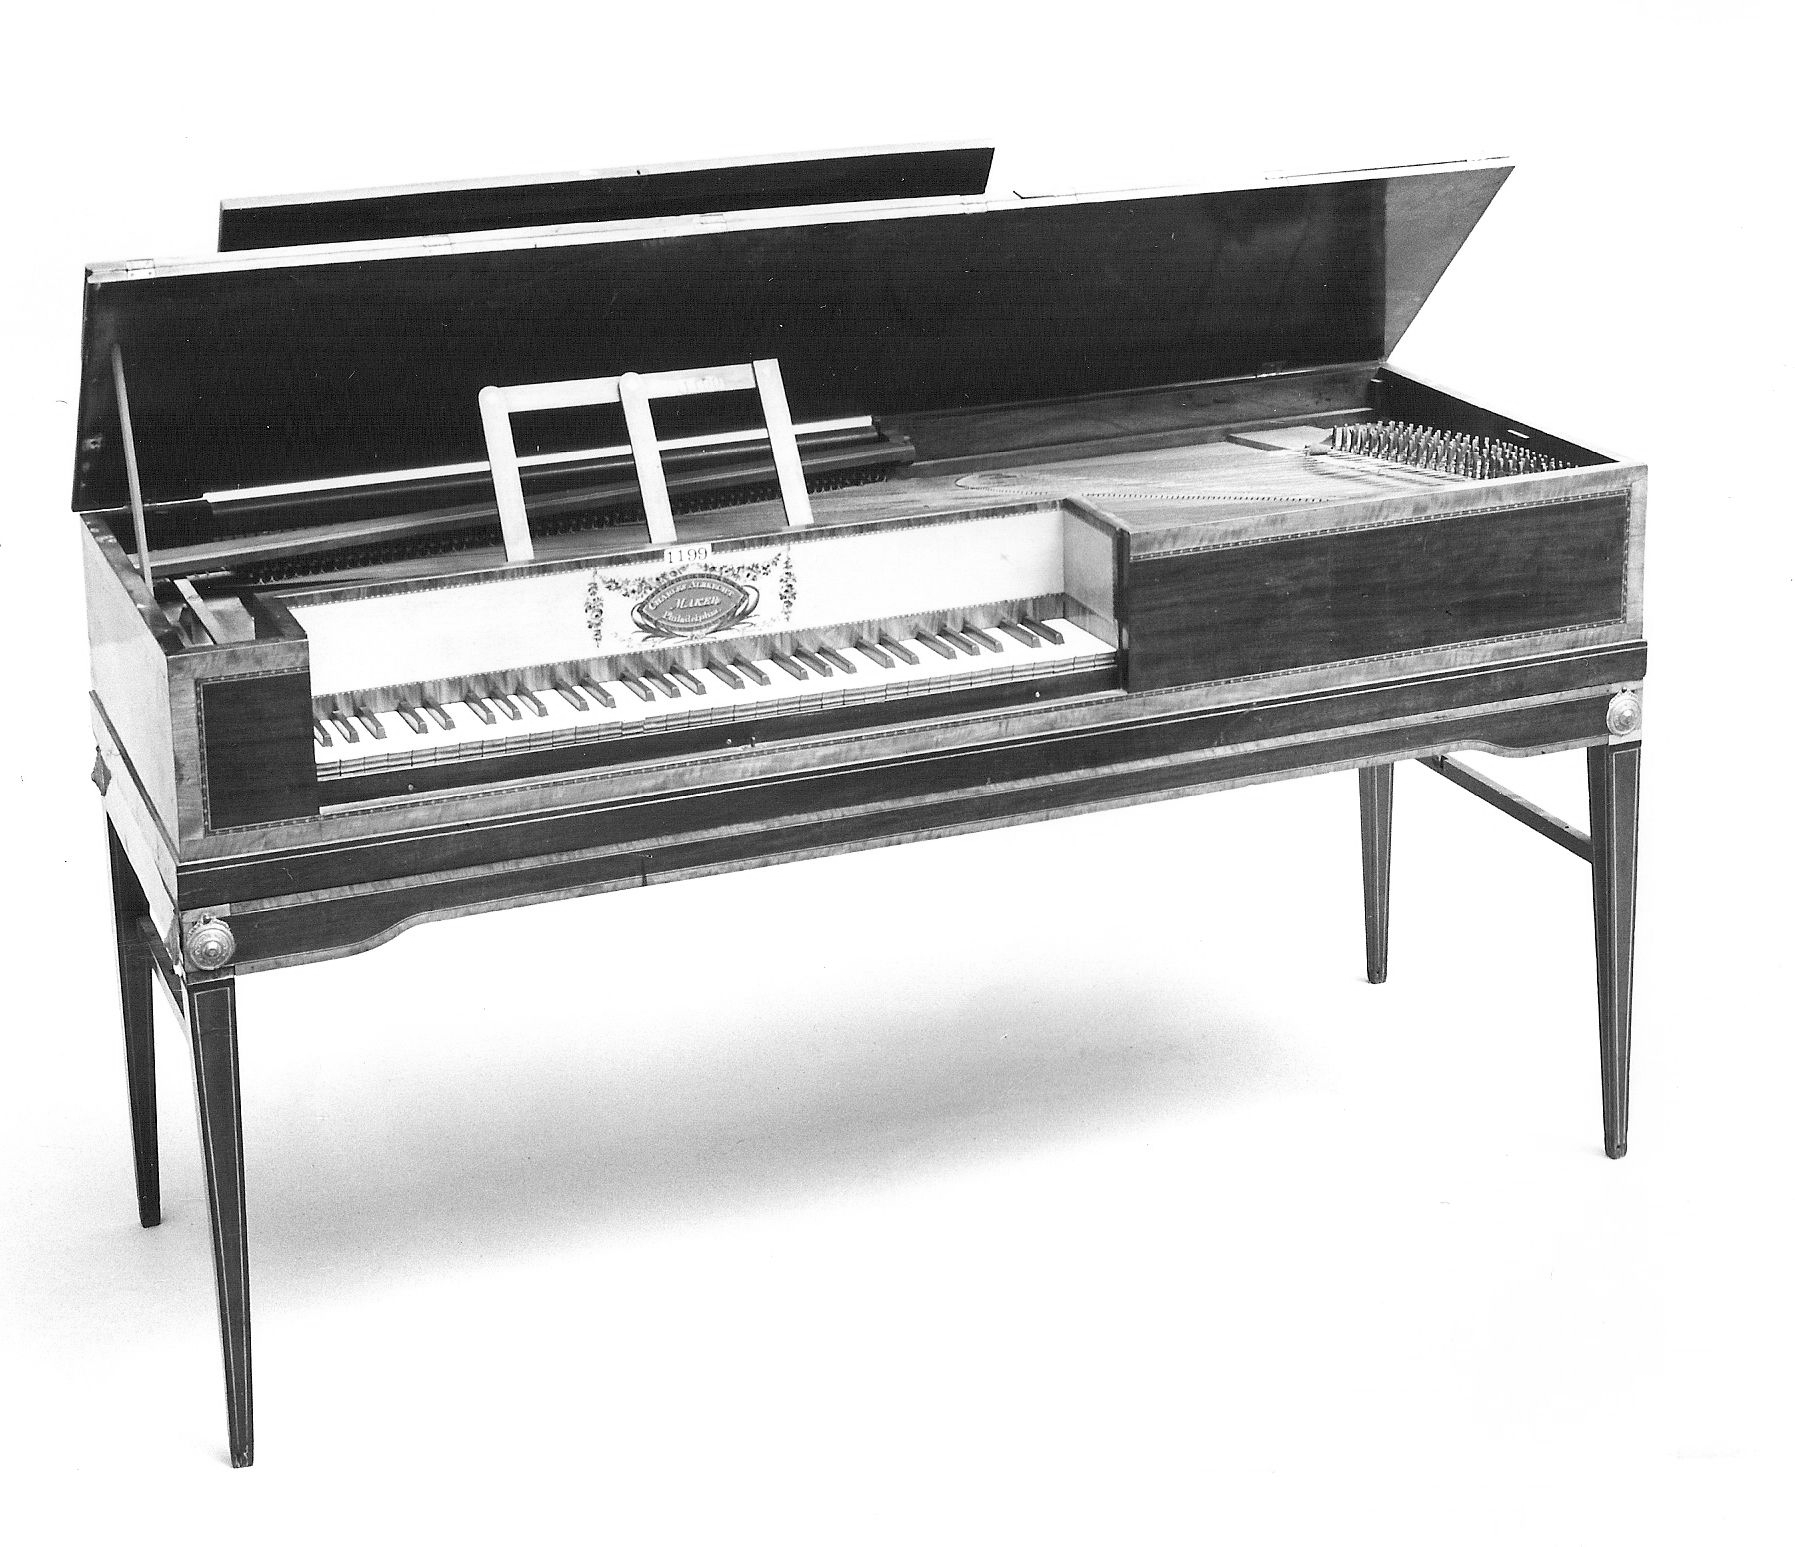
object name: square piano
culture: american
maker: charles albrecht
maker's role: maker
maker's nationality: german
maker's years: 1759-1848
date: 1791-1798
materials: brass, wood, ivory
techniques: veneering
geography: united states